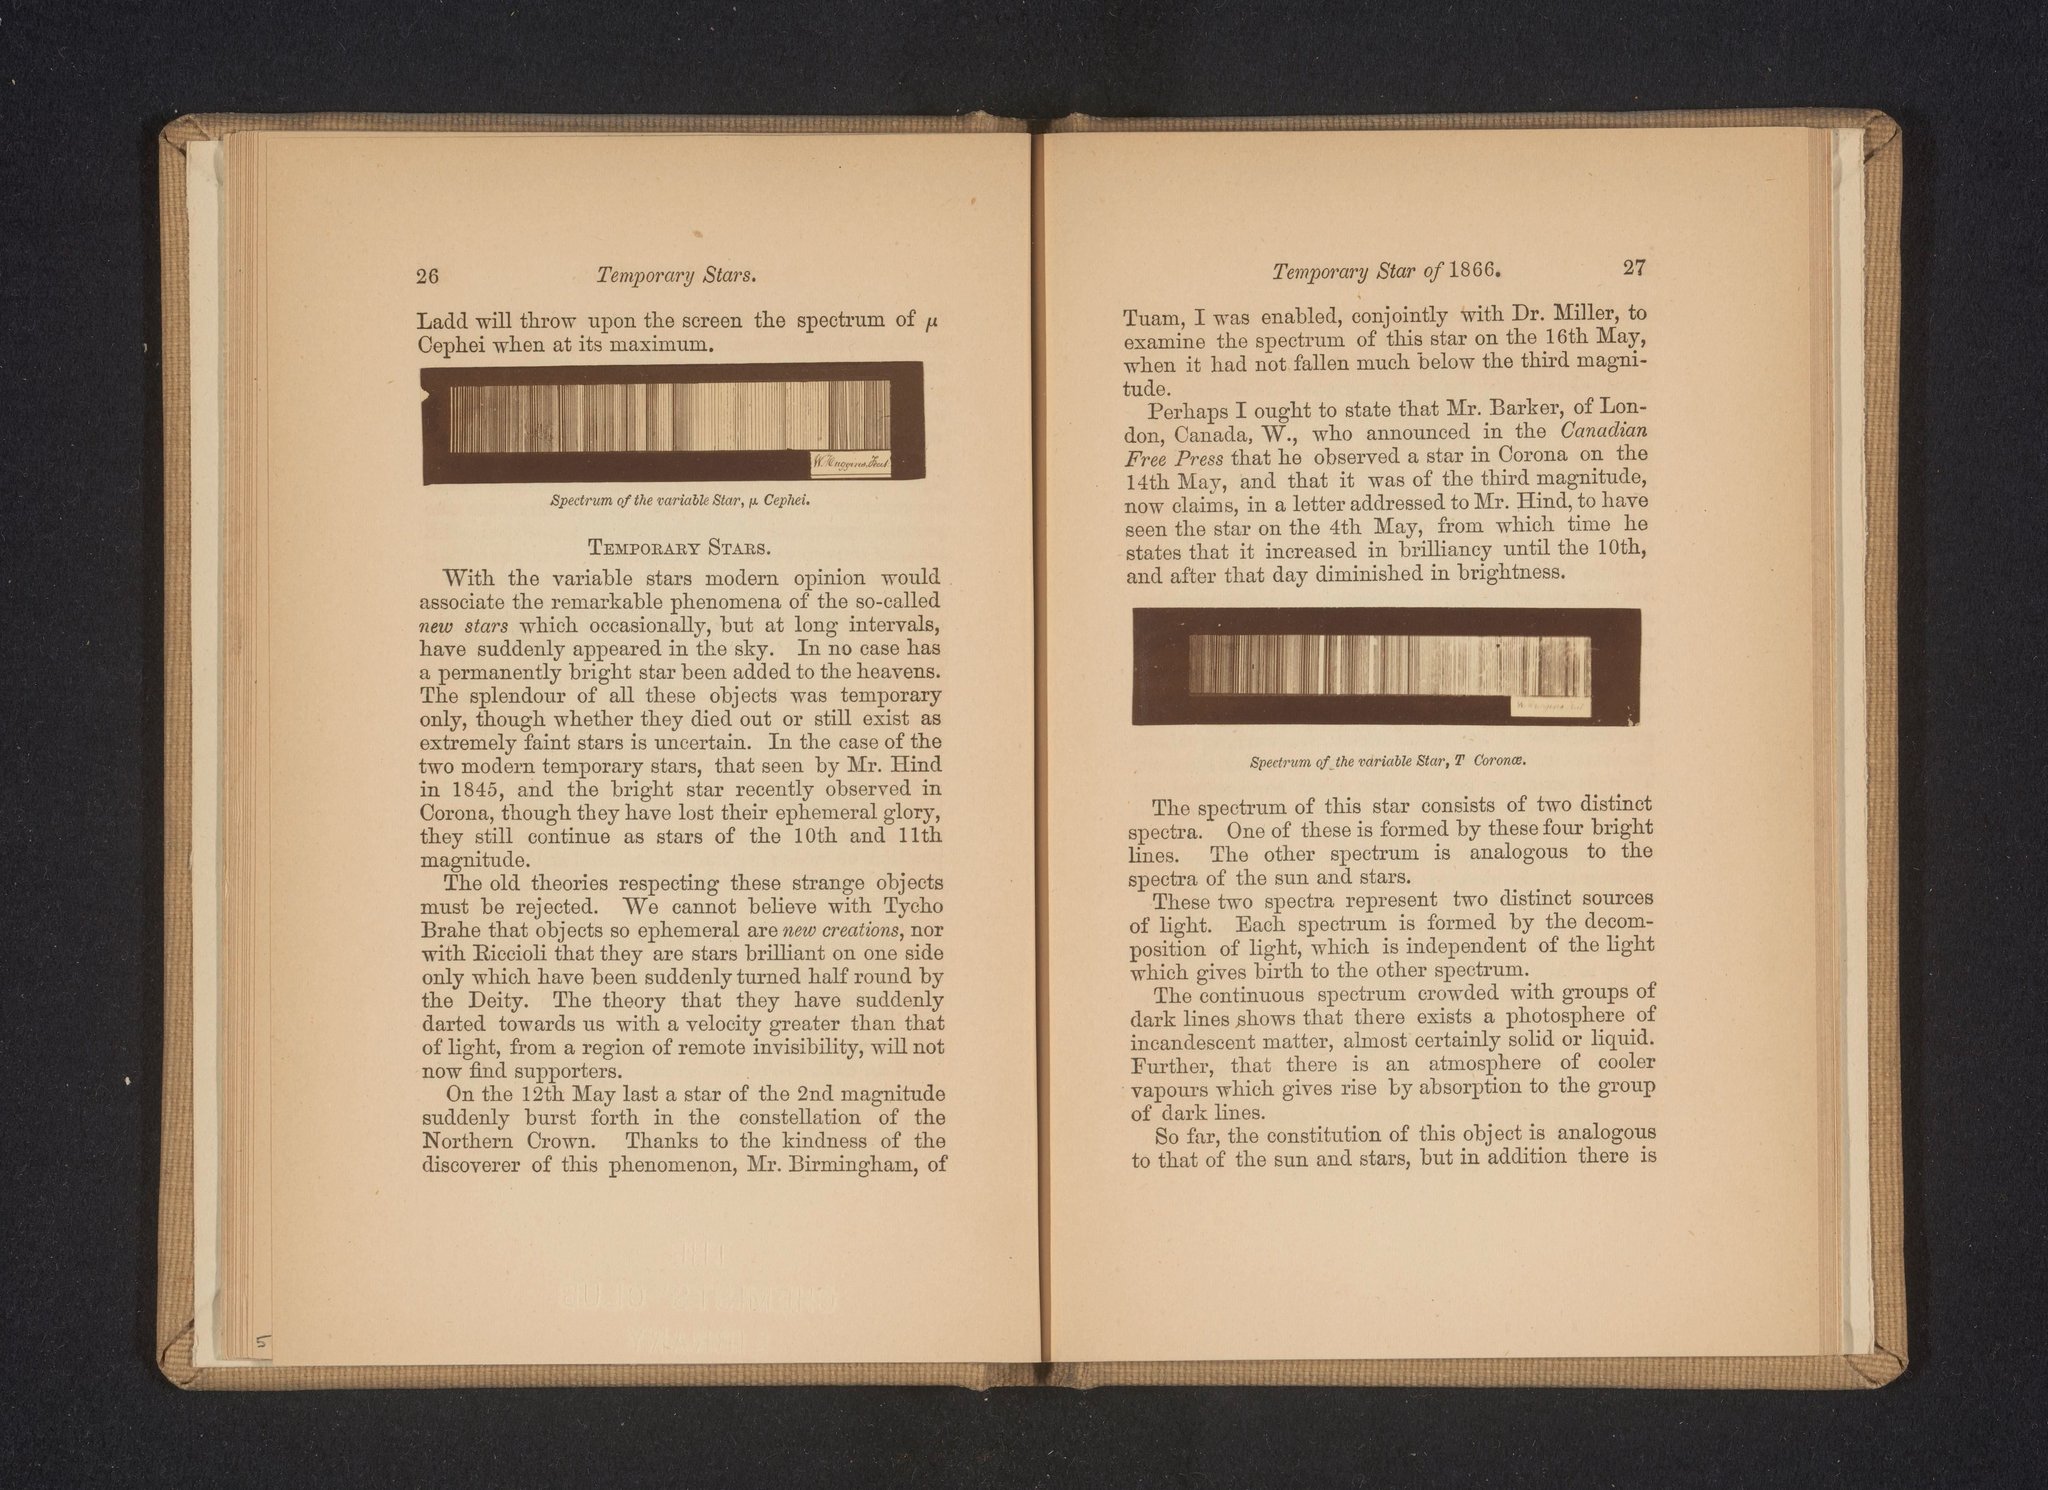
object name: photograph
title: Spectrum of the variable Star, µ Cephei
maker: Anonymous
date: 1856-1866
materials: photographic support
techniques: albumen print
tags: stars and constellations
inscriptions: name: ‘W. Huggins [...]’